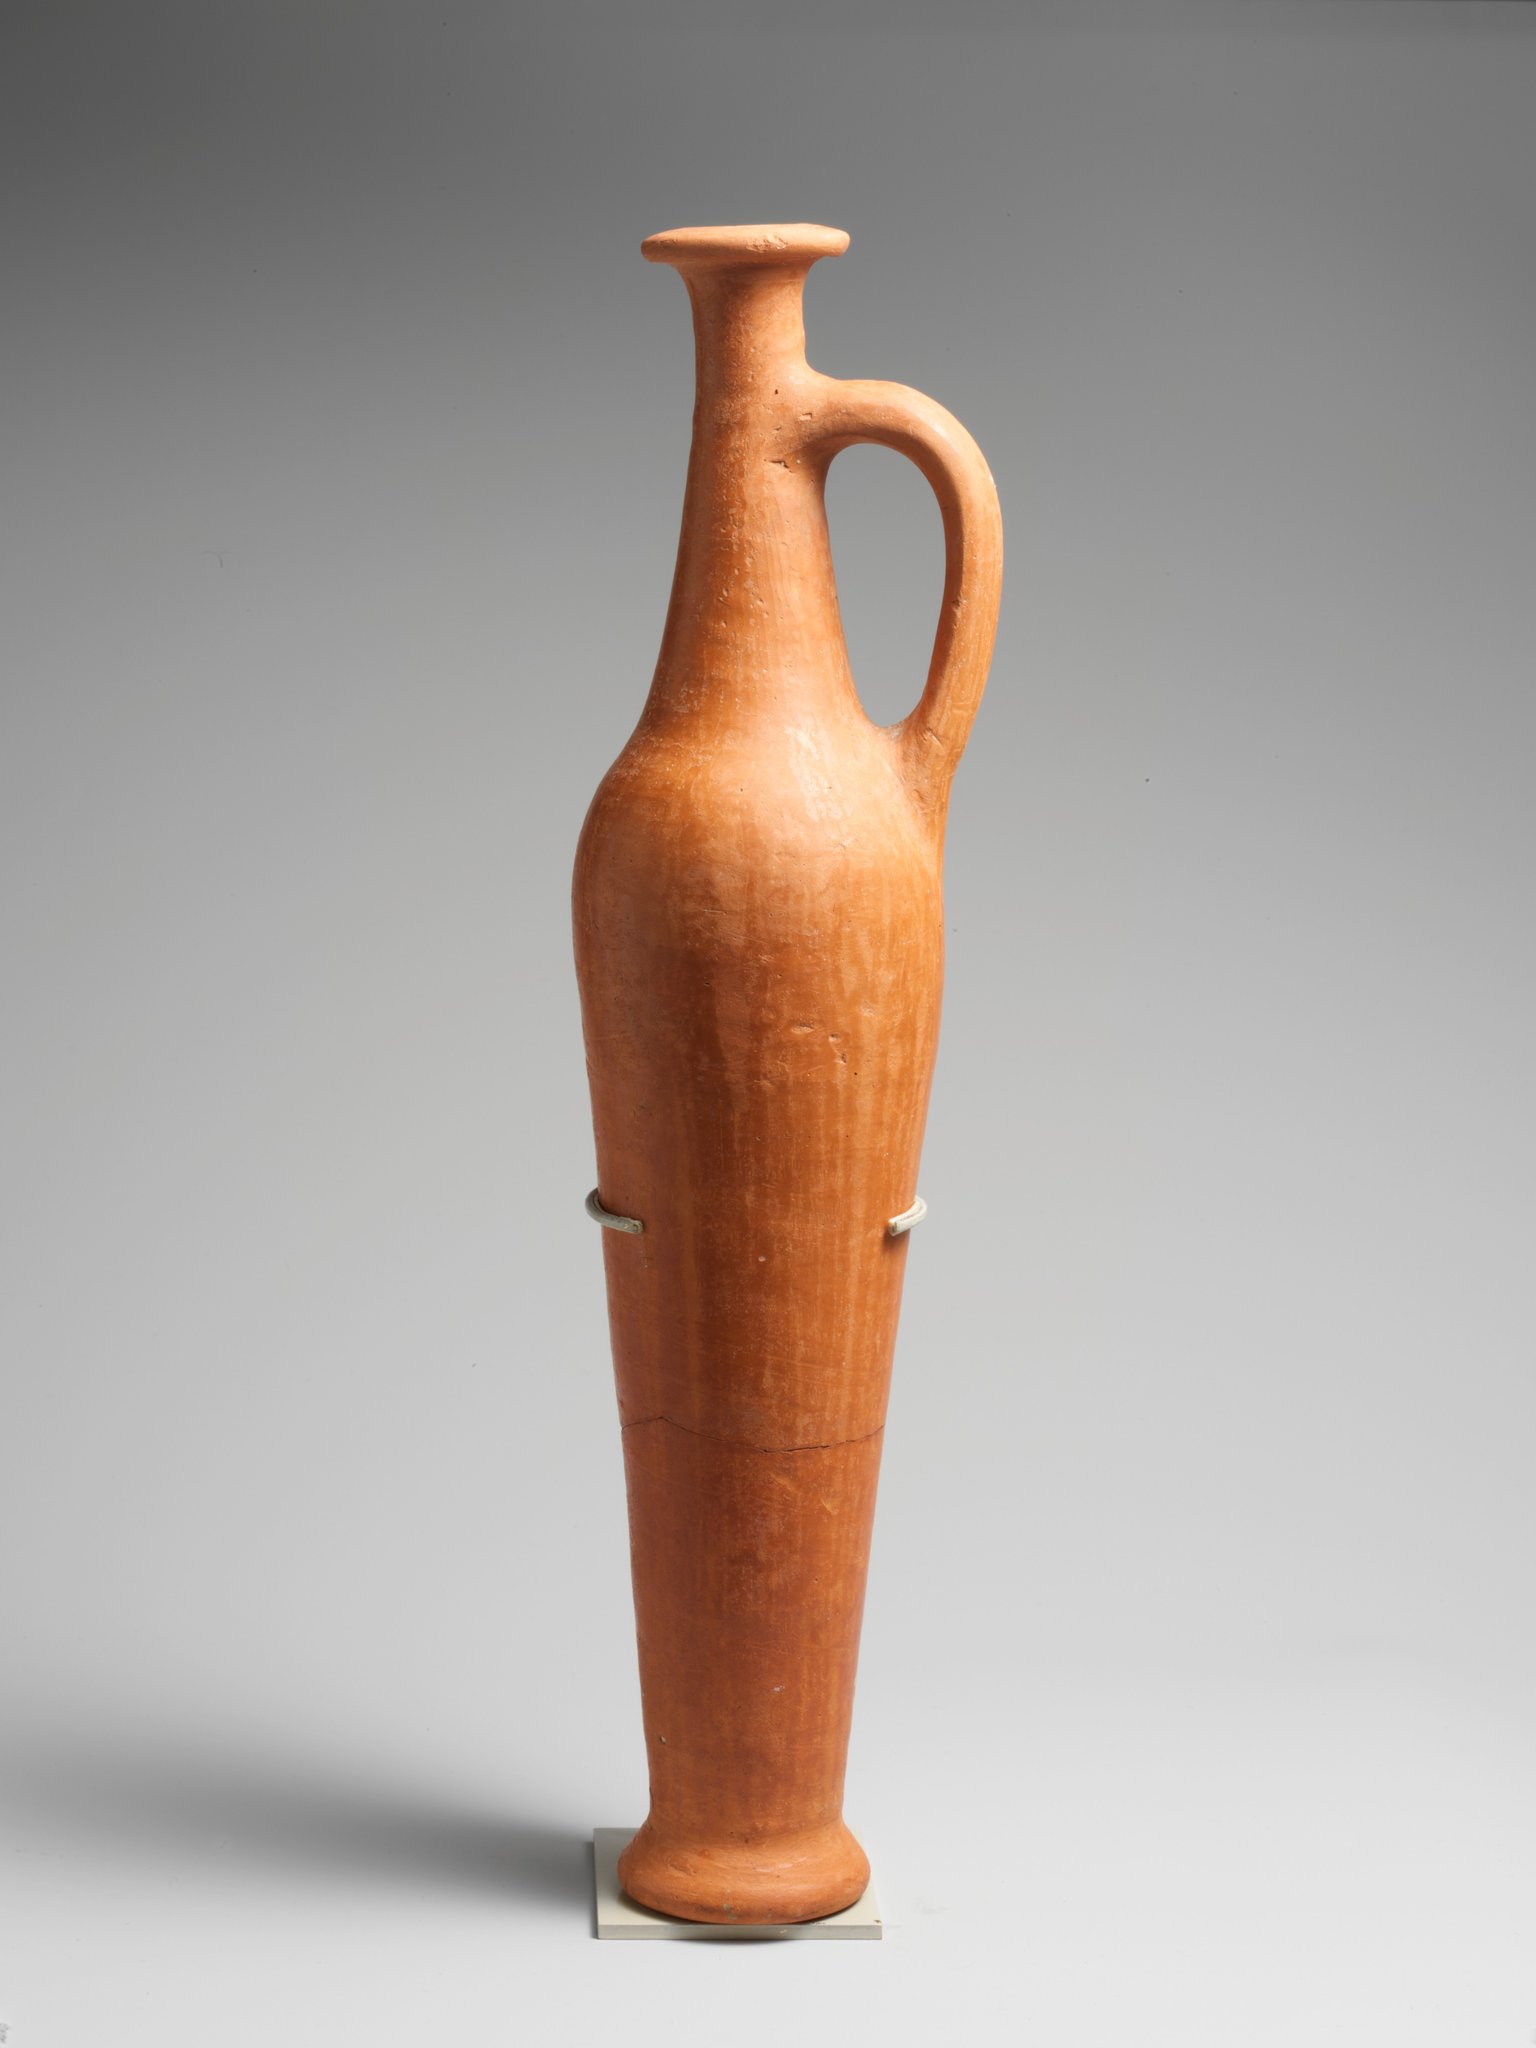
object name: spindle bottle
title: Terracotta spindle bottle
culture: cypriot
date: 1600-1050 BCE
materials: terracotta